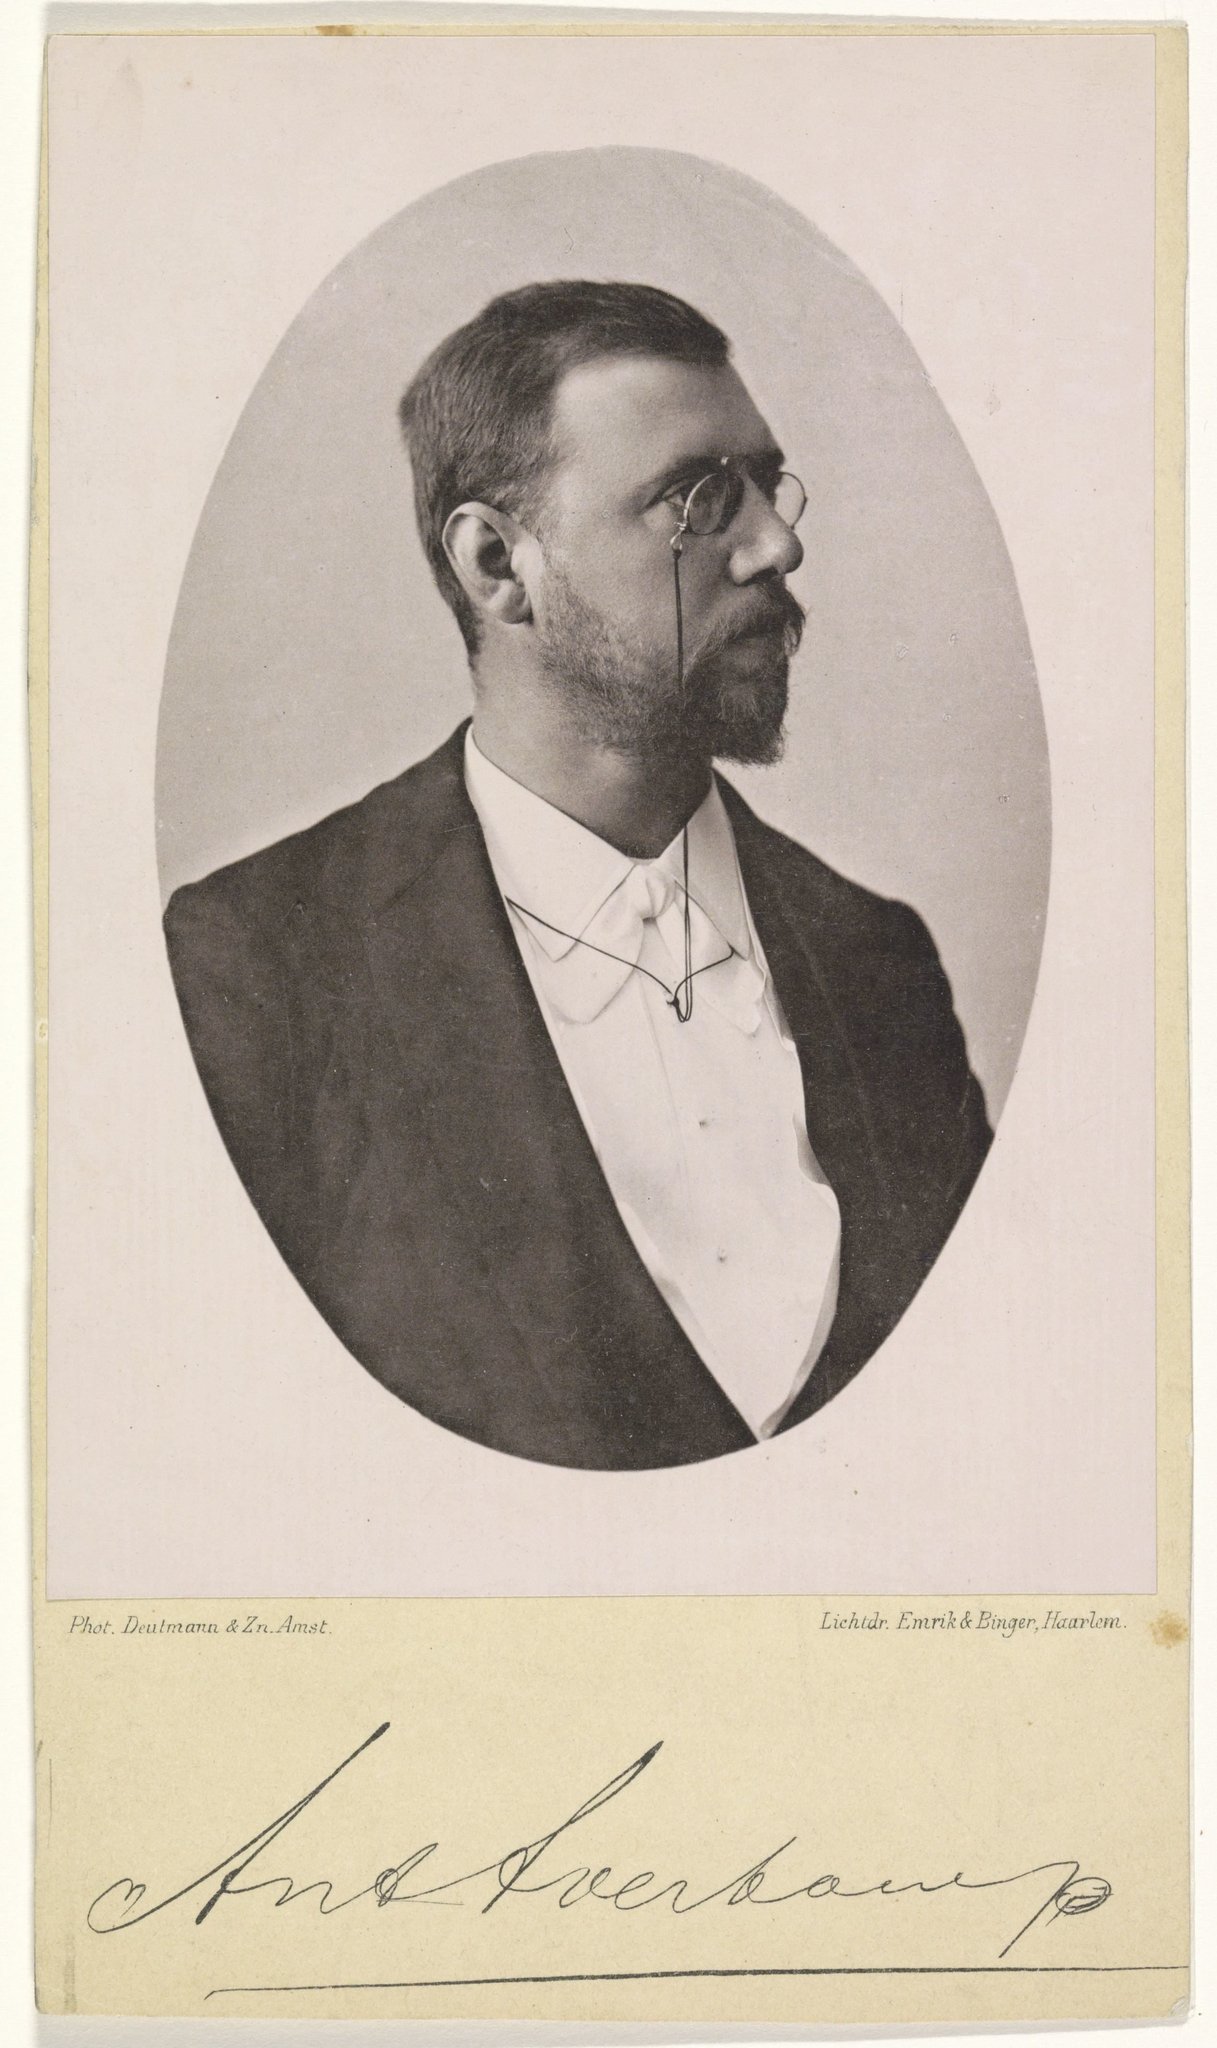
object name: photograph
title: Ovaal portret van A. Averkamp, Nederlands componist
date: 1893-1896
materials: cardboard, paper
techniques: photograph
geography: amsterdam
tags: historical persons, portrait of composer, netherlands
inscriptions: name: ‘Phot. Deutmann & Zn. Amst / Lichtdr. Emrik & Binger. Haarlem’, annotation: ‘Ant Averkamp’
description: H.A. Viotta, Onze hedendaagsche toonkunstenaars, 1893-1896